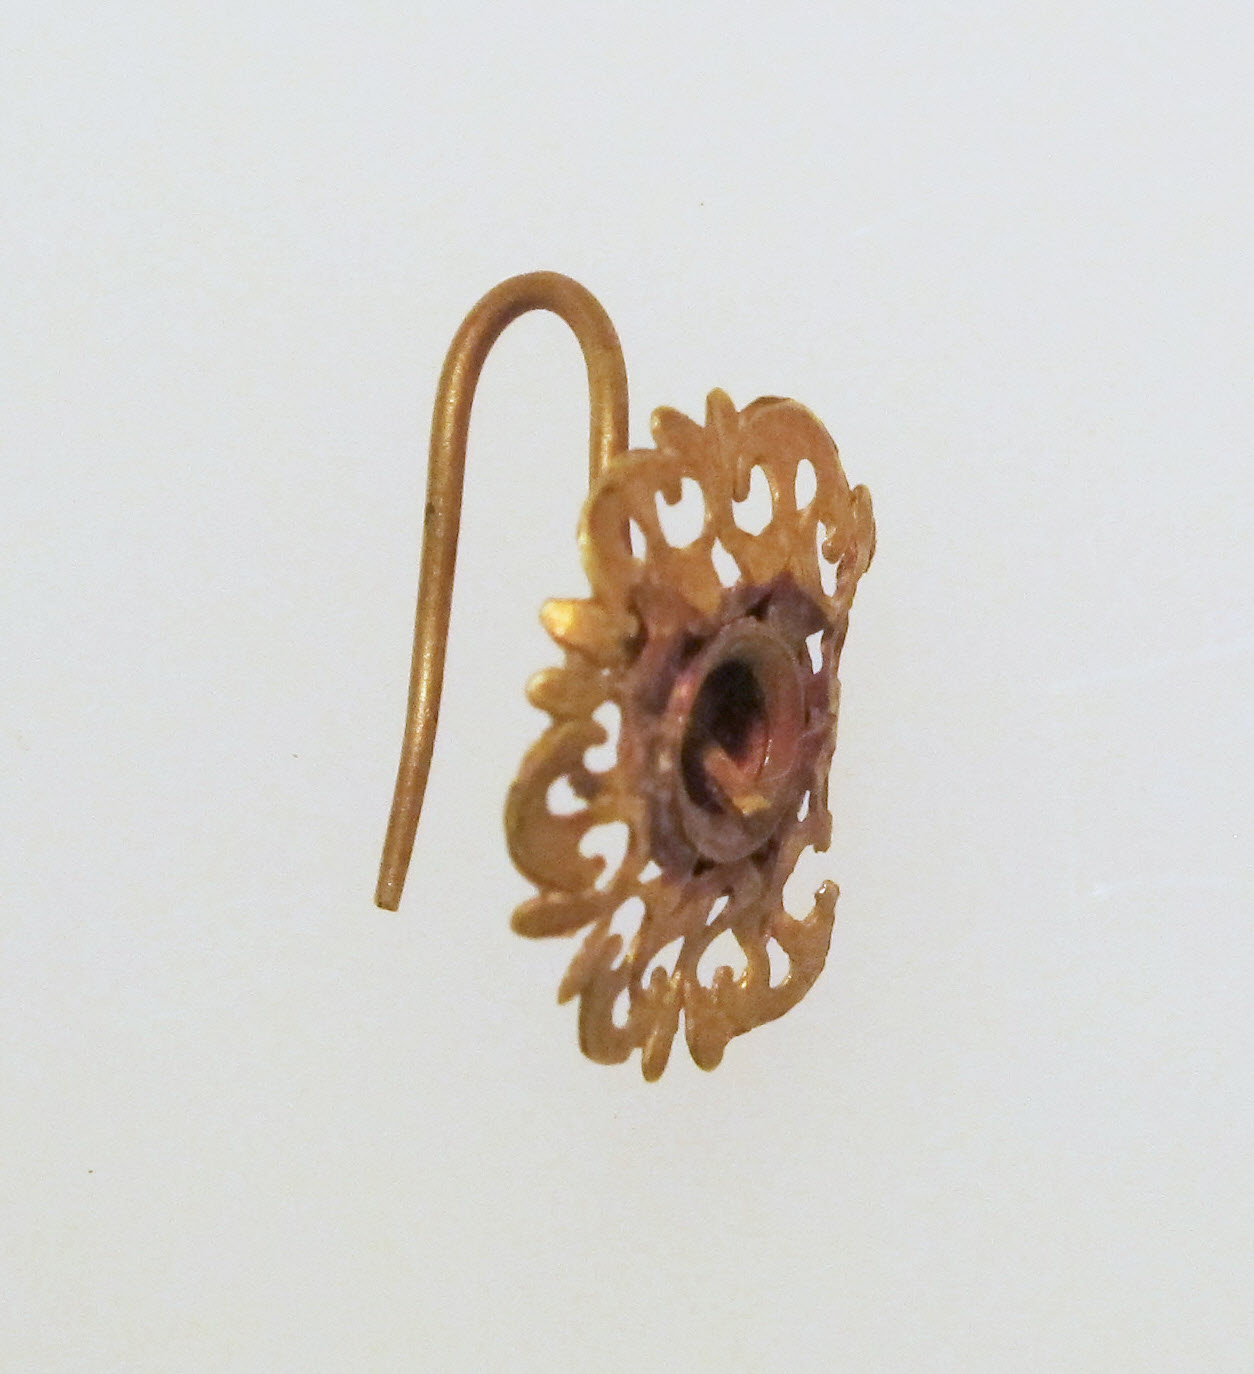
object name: earring hook type with disc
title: Earring-hook type with disc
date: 7000 BCE-330 CE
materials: gold